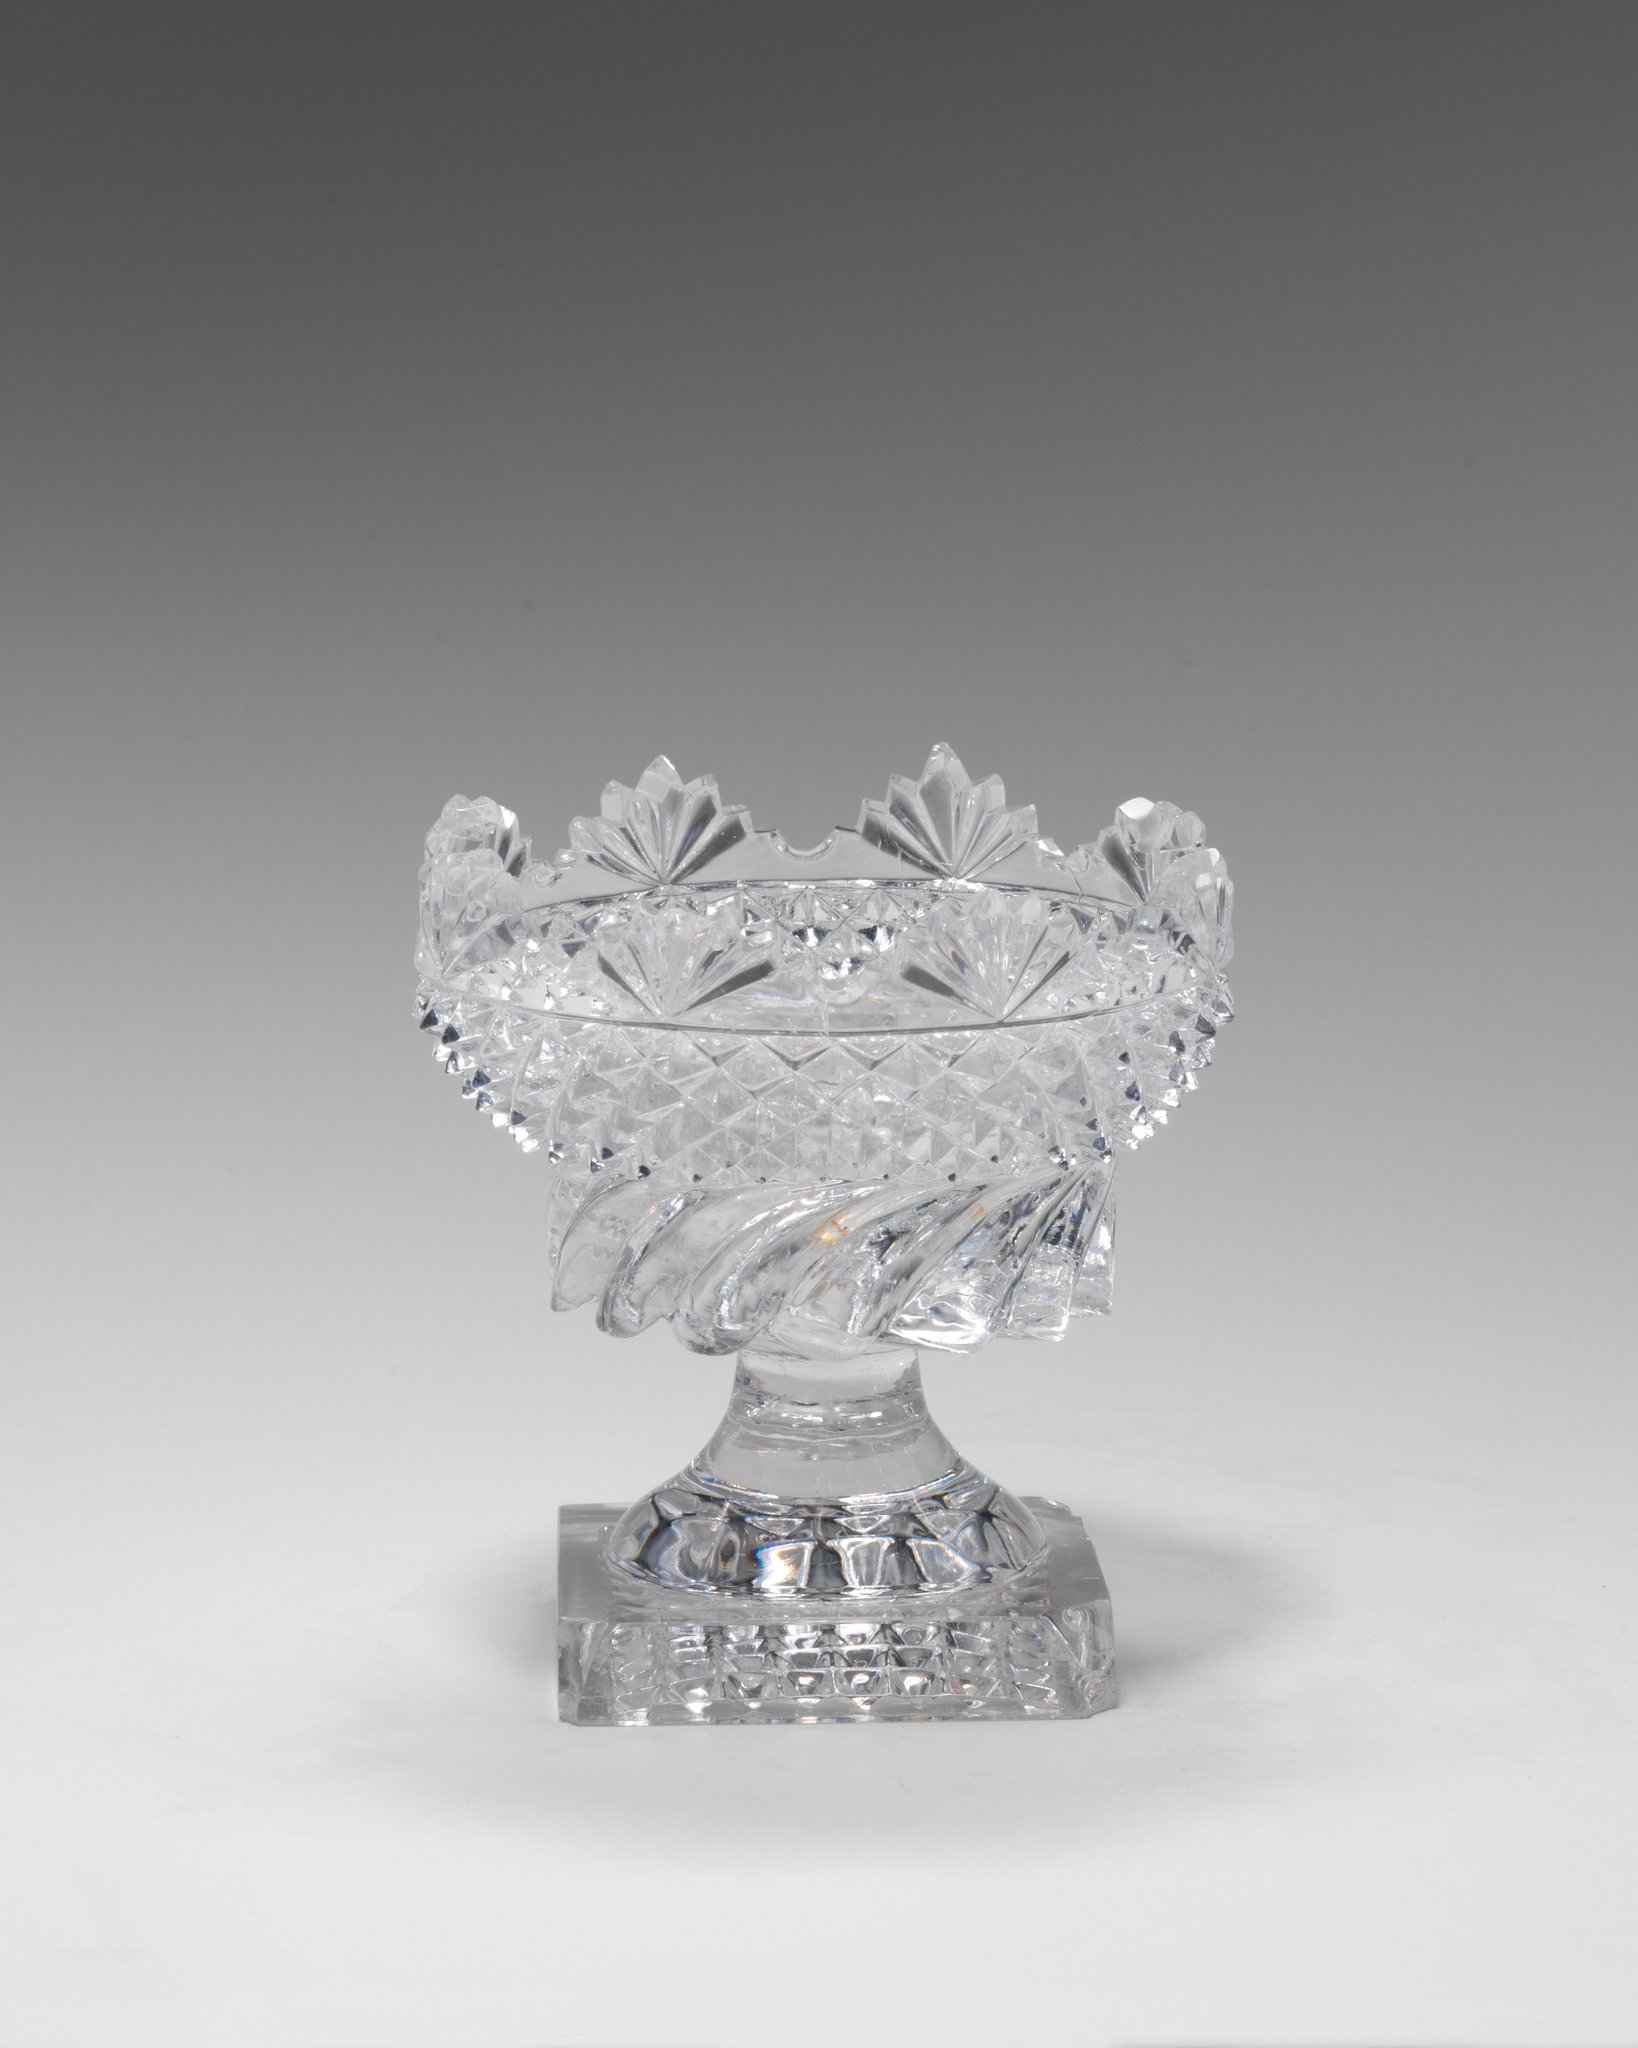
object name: salt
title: Salt (one of a pair)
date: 1801-1833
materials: glass